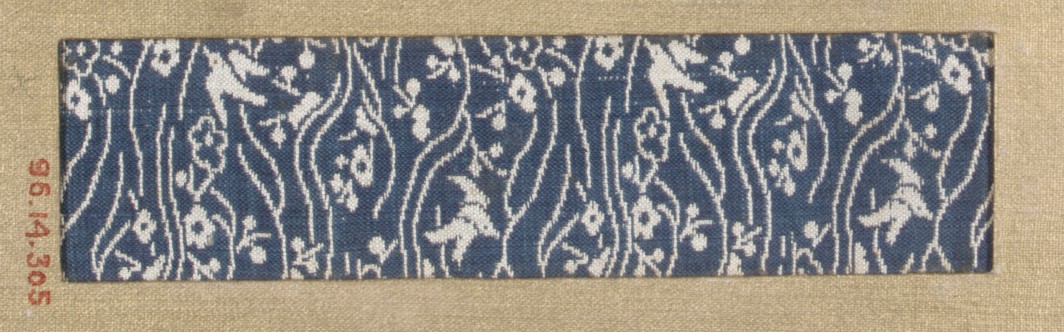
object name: piece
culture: japanese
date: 1701-1900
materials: silk